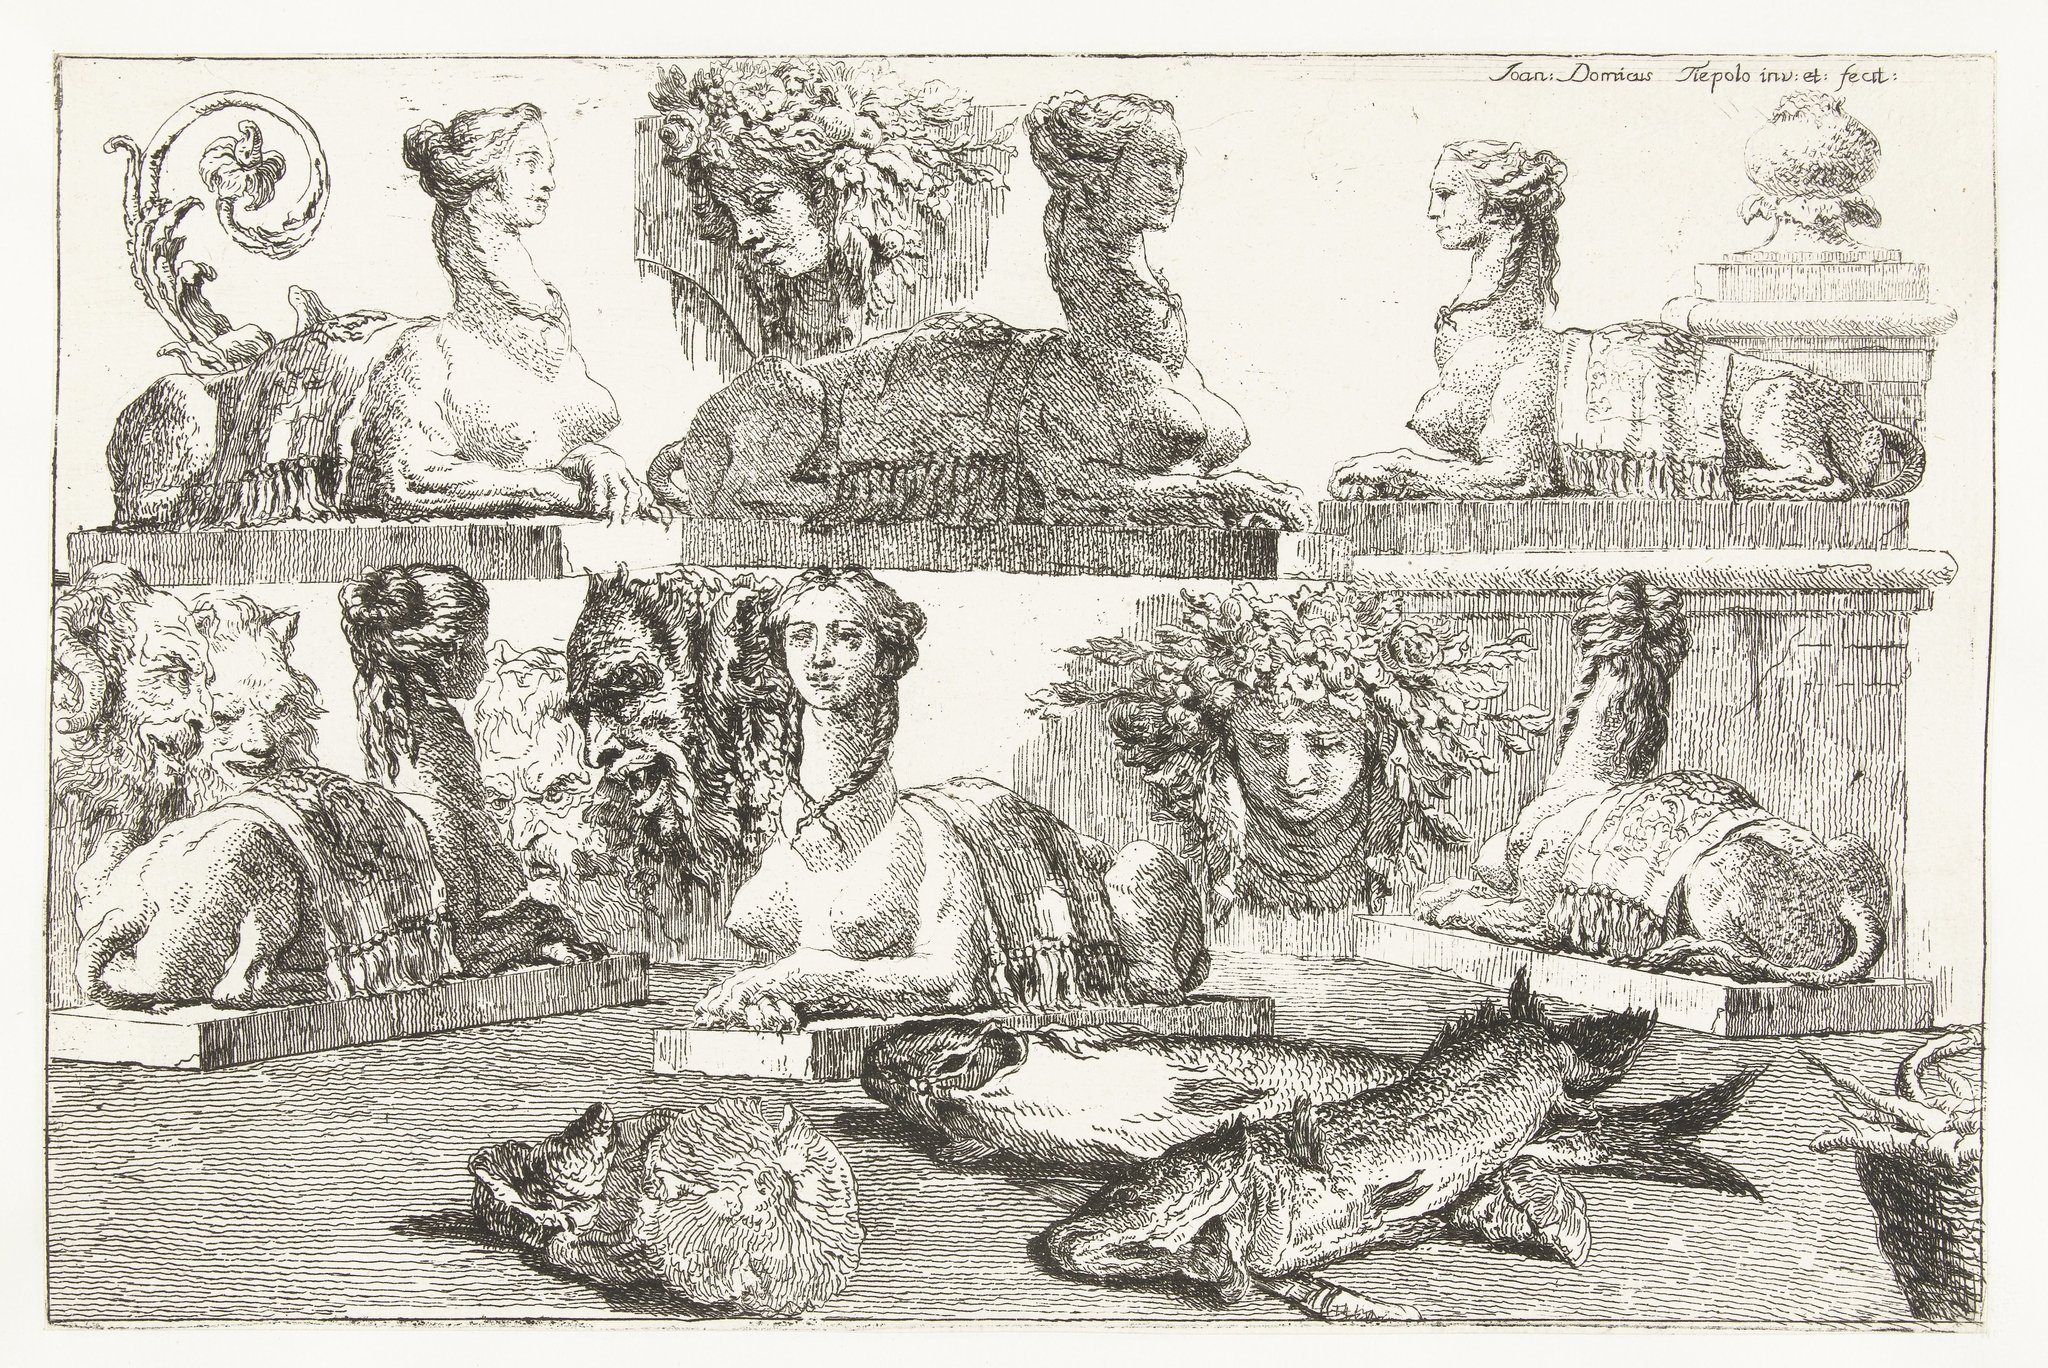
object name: print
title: Studies van sfinxen en vissen en hoofden van saters en Flora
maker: giovanni domenico tiepolo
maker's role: draughtsman, print maker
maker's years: 1727-1804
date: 1751-1755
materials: paper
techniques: etching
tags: sphinx (lion/woman); 'sfinge' (ripa), satyr(s) (in general), (story of) flora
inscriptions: collector's mark: Lugt 2228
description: Prent met studies naar thema's uit het werk van Govanni Battista Tiepolo (Rizzi 1971, p. 334).